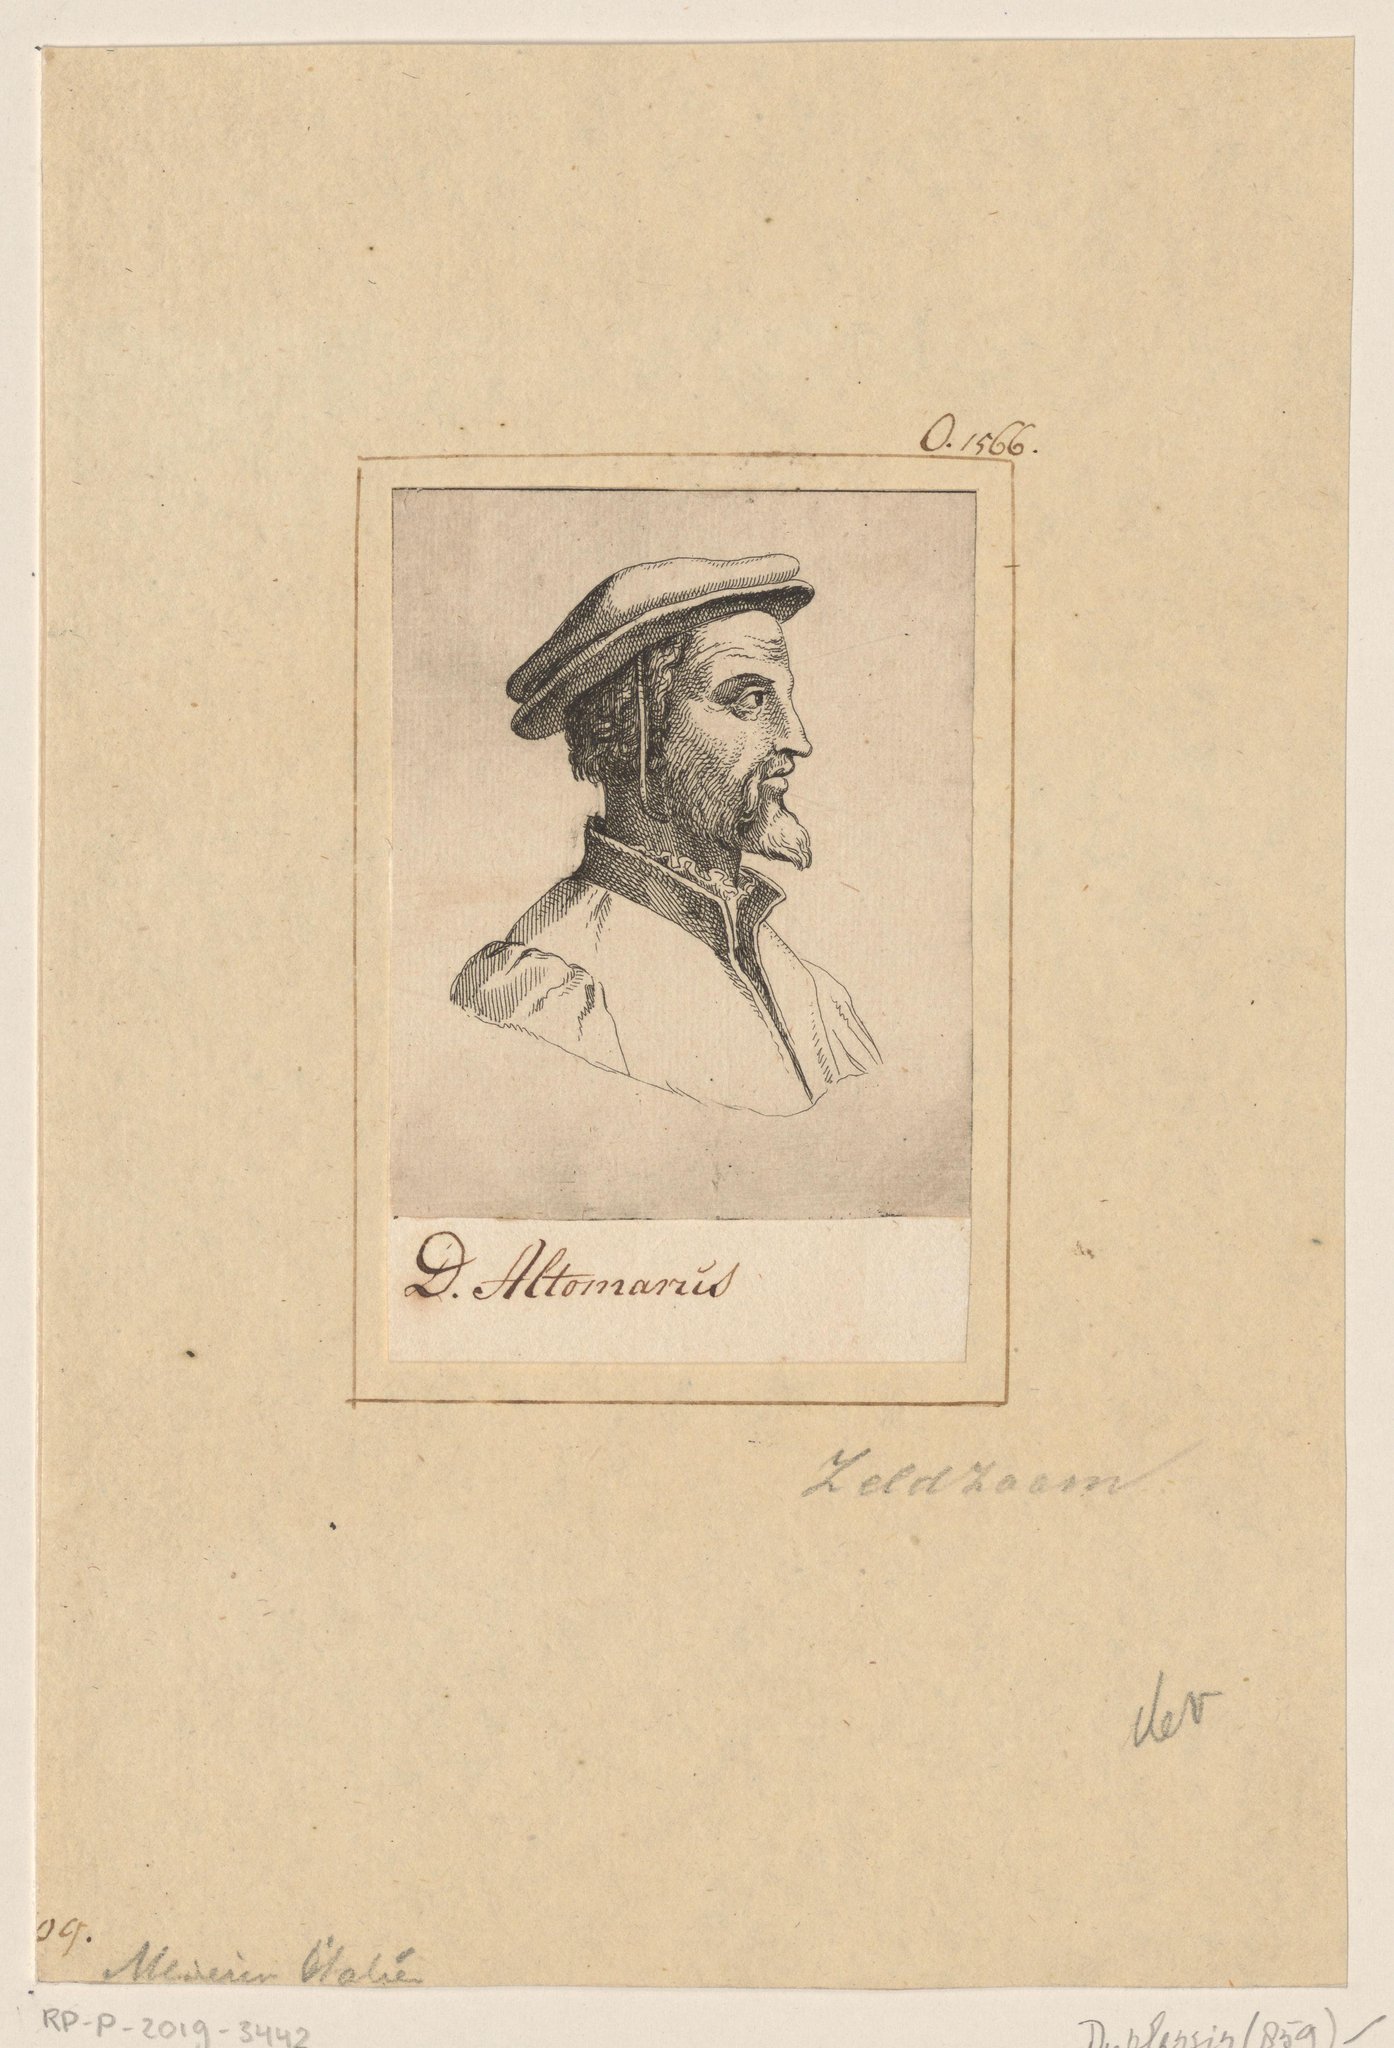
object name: print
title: Portret van Donato Antonio Altomari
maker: Anonymous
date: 1600-1649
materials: paper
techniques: etching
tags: historical persons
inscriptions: inscription: ‘D. Altomarius’